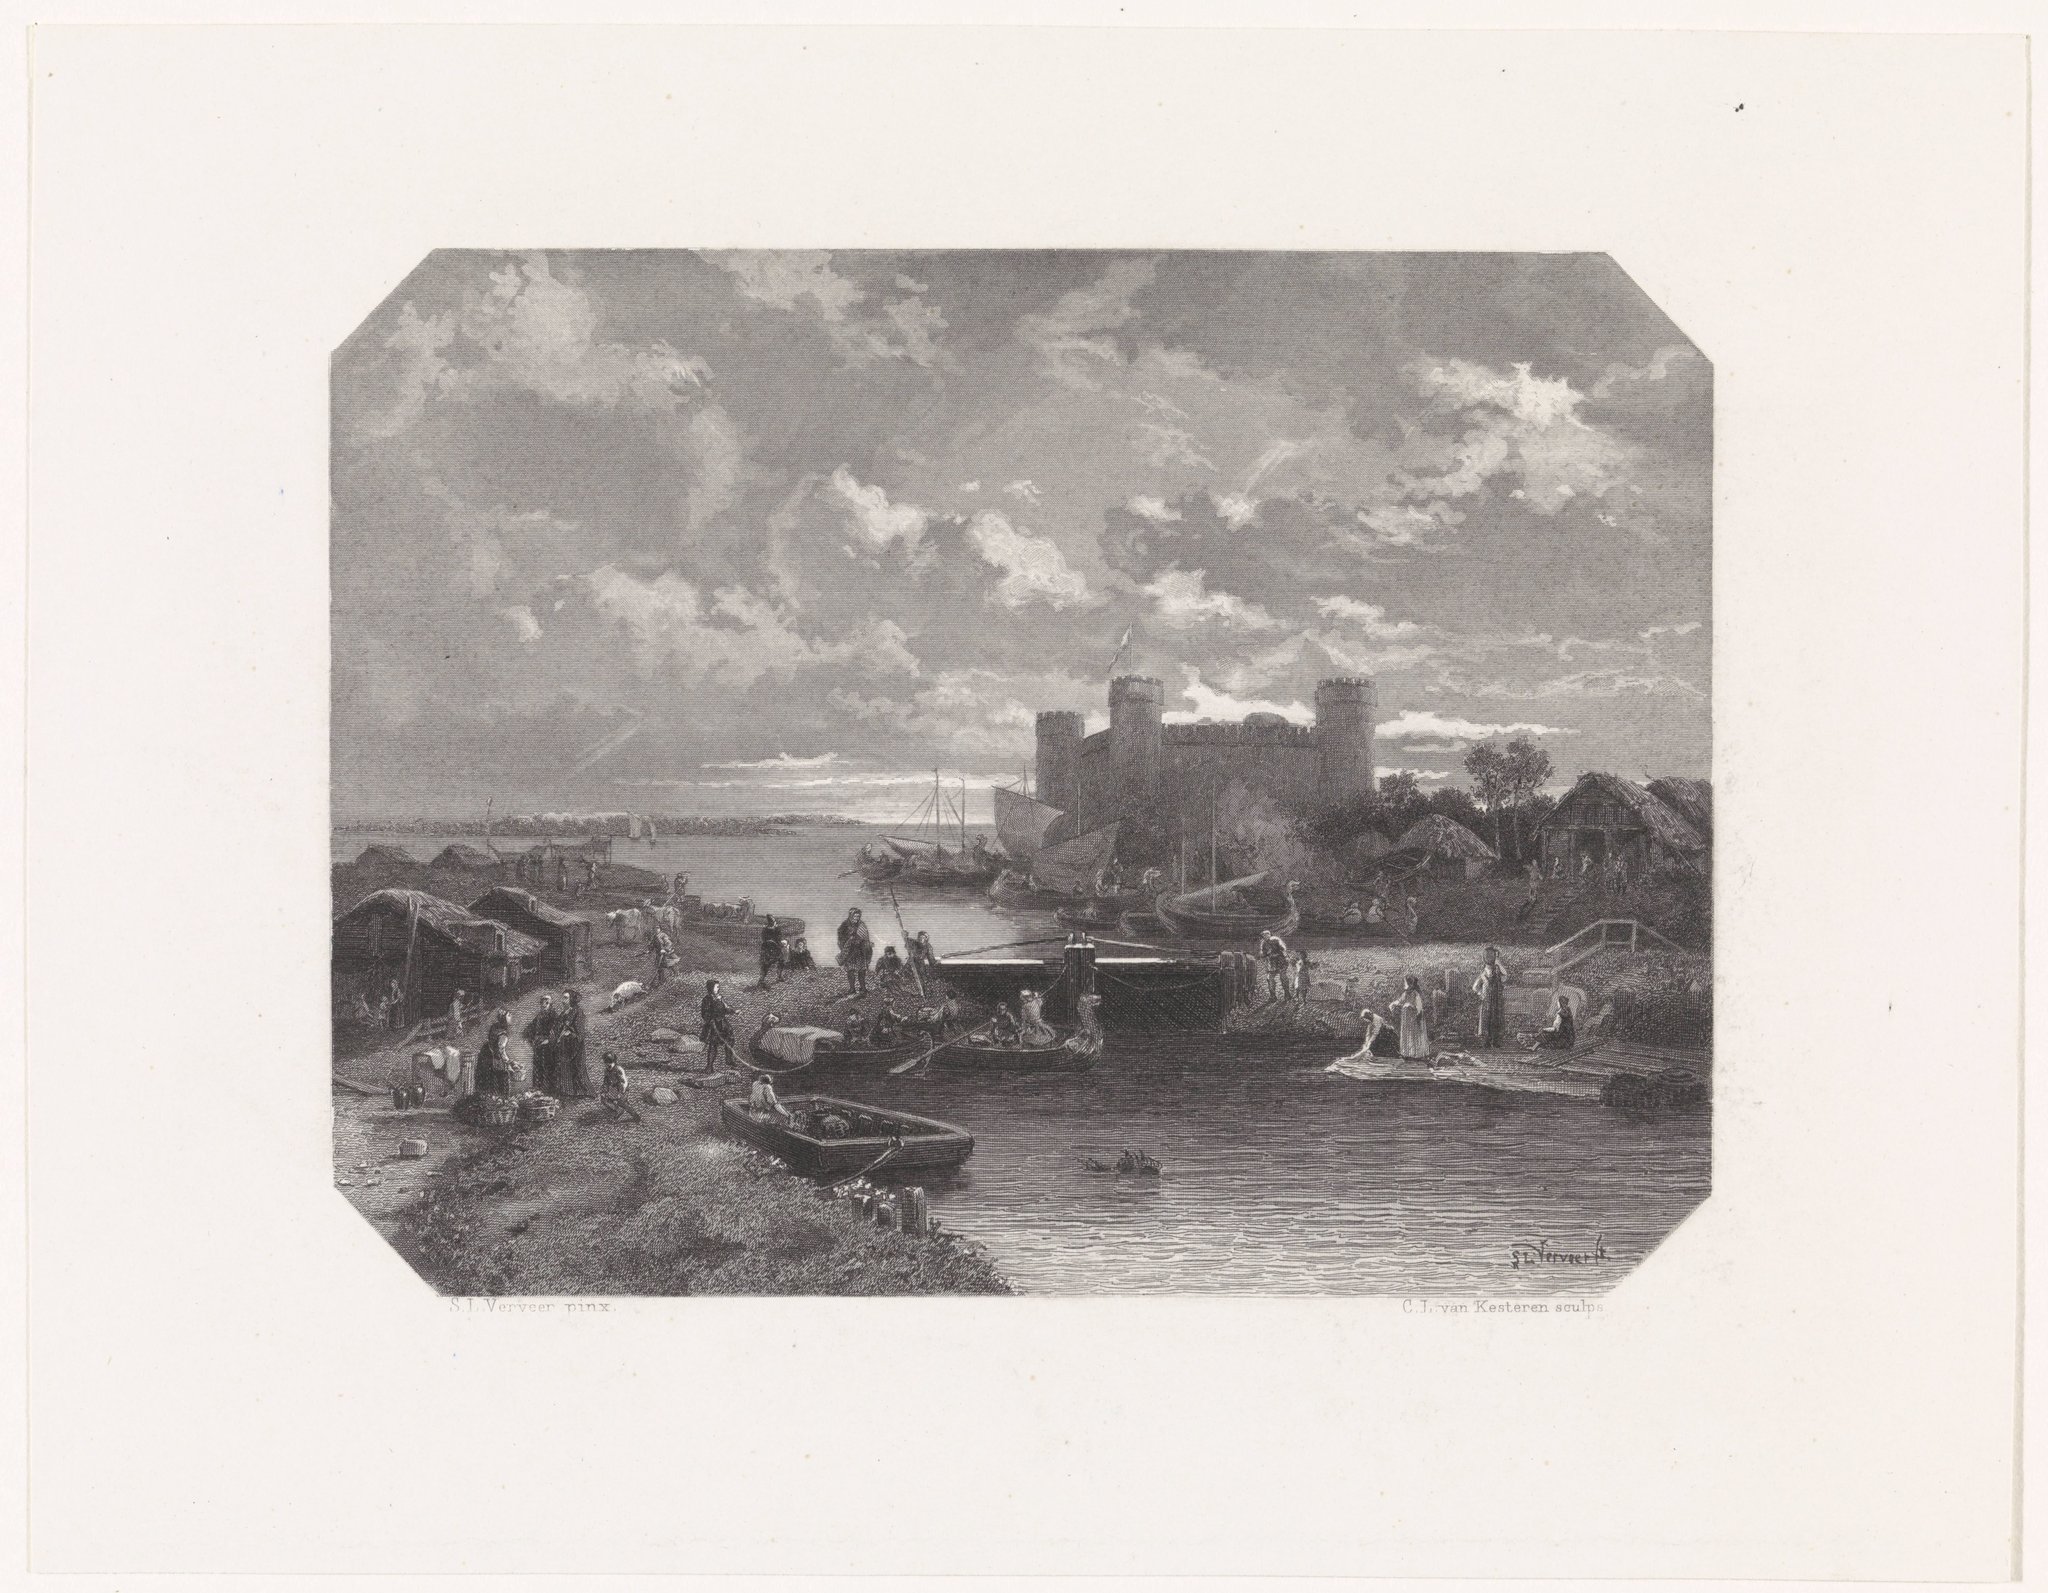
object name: history print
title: Muiden in de 10e eeuw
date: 1865-1870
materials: paper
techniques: engraving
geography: netherlands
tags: muiden, nederland tijdens de late middeleeuwen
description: Illustratie voor: J. van Lennep en W. Moll en J. ter Gouw, Nederlands geschiedenis en volksleven in schetsen, A.W. Sijthoff, Leiden ca. 1870. Staalgravures naar de schilderijen van de Historische Galerij der Maatschappij Arti en Amicitiae.